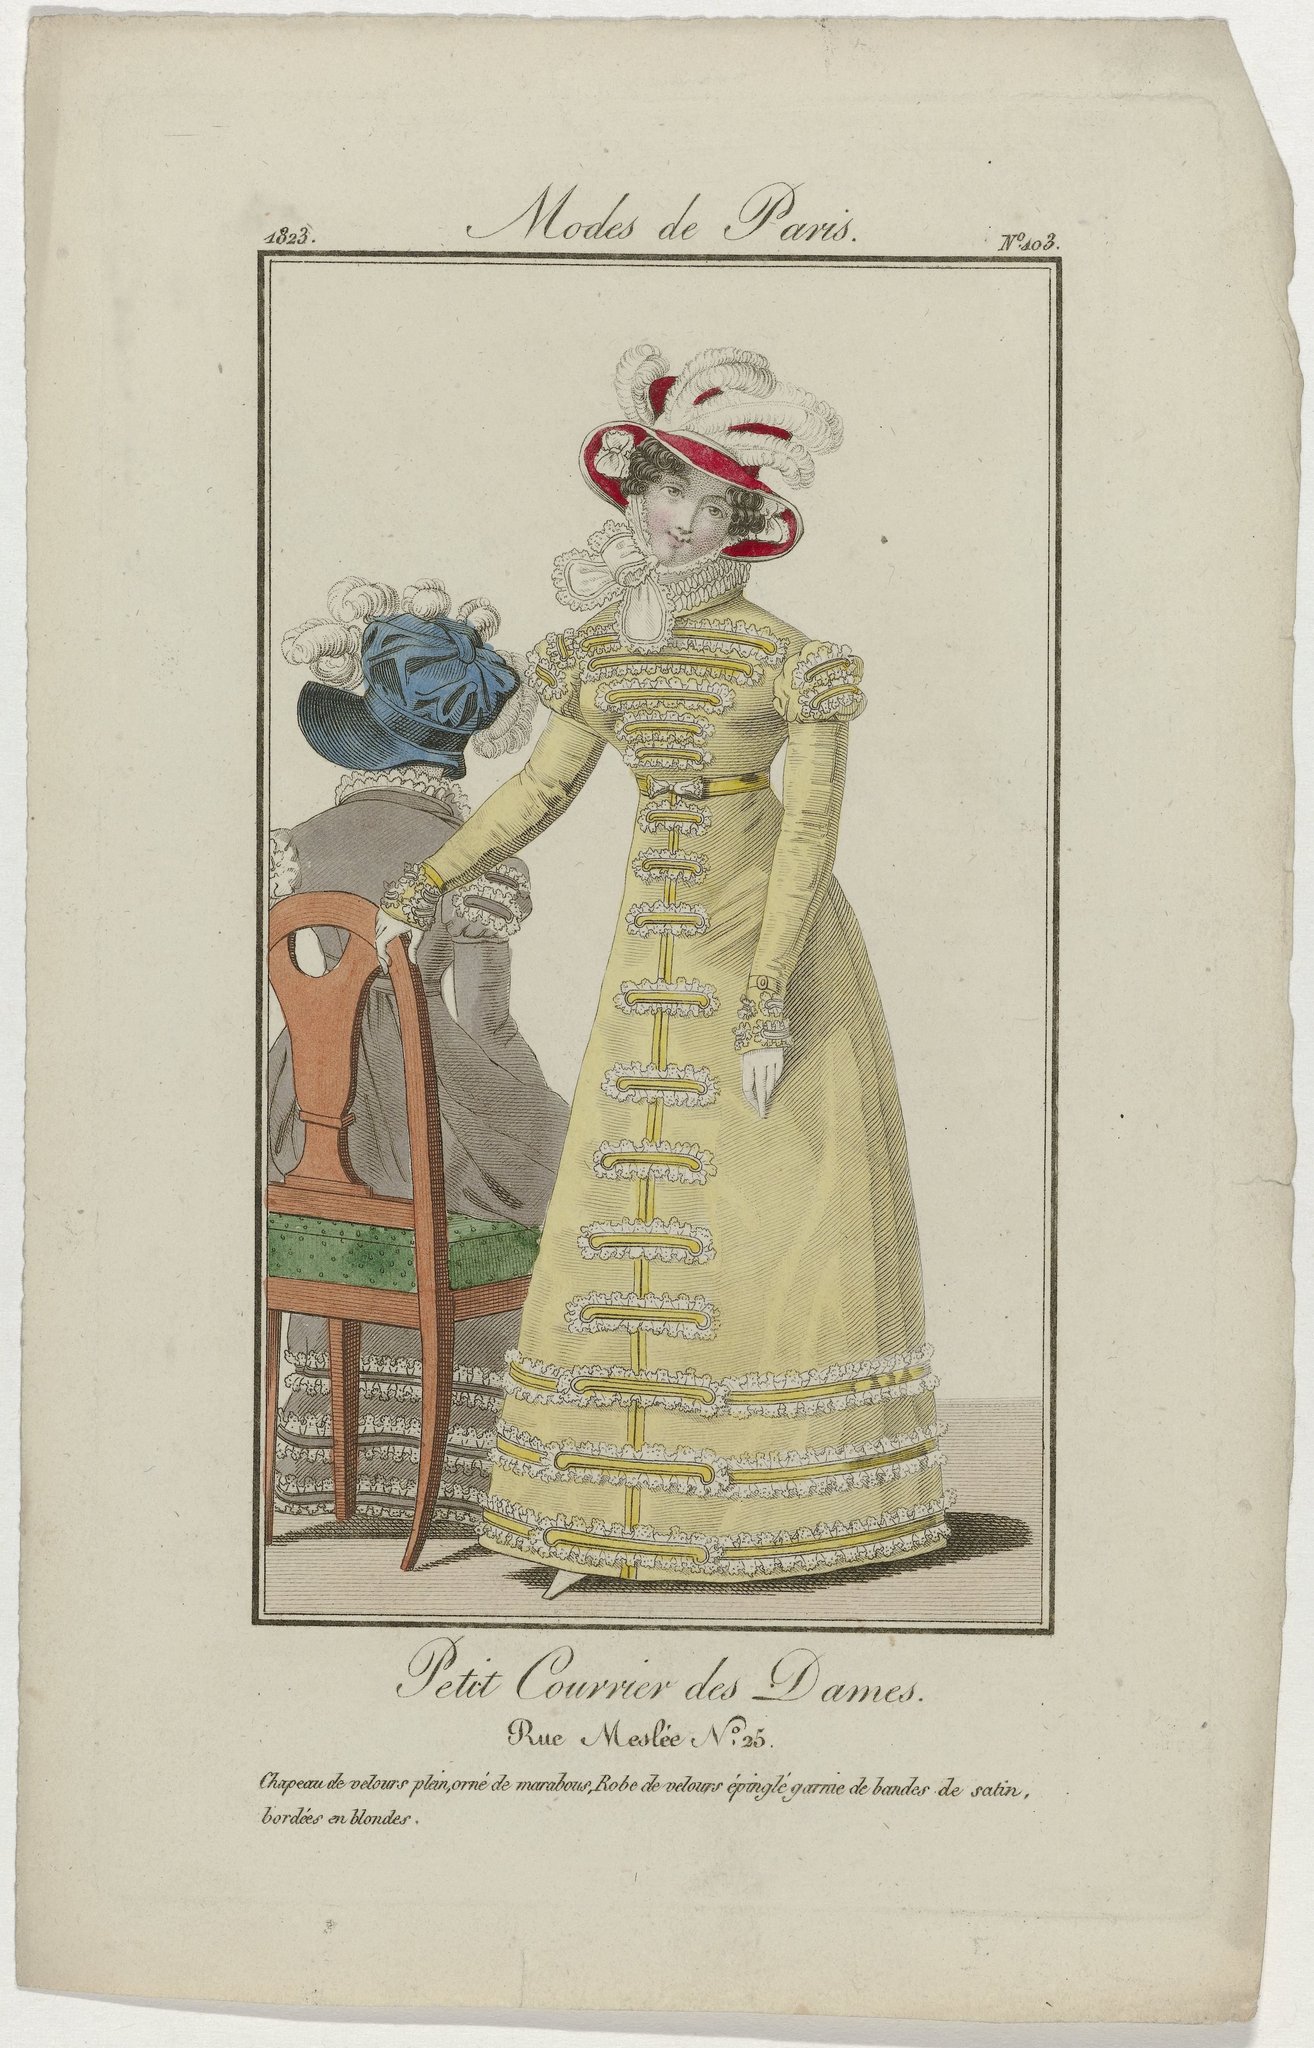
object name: fashion print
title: Petit Courrier des Dames, 1823, No. 103 : Chapeau de velours plein (...)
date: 1823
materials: paper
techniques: engraving, hand coloring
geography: paris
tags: ornamental parts of clothing (+ women's clothes), fashion plates, head-gear: hat (+ women's clothes), dress, gown (+ women's clothes), chair, neck-gear ~ clothing (+ women's clothes), belt, girdle, waistband (+ women's clothes)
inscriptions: title: ‘Modes de Paris.’, address: ‘Rue Meslée No.25.’, caption: ‘Chapeau de velours plein, orné de marabous, Robe de velours épinglé garnie de bandes de satin, bordées en blondes.’, title: ‘Petit Courrier des Dames.’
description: Staande vrouw met op het hoofd een hoed van effen fluweel , versierd met maraboeveren. ZIj draagt een japon van 'velours épinglé', versierd met banden van satijn, afgezet met Blonde (kloskant). Links een zittende vrouw op een stoel, op de rug gezien, gekleed in eenzelfde japon. Prent uit het modetijdschrift Petit Courrier des Dames (1821-1868).